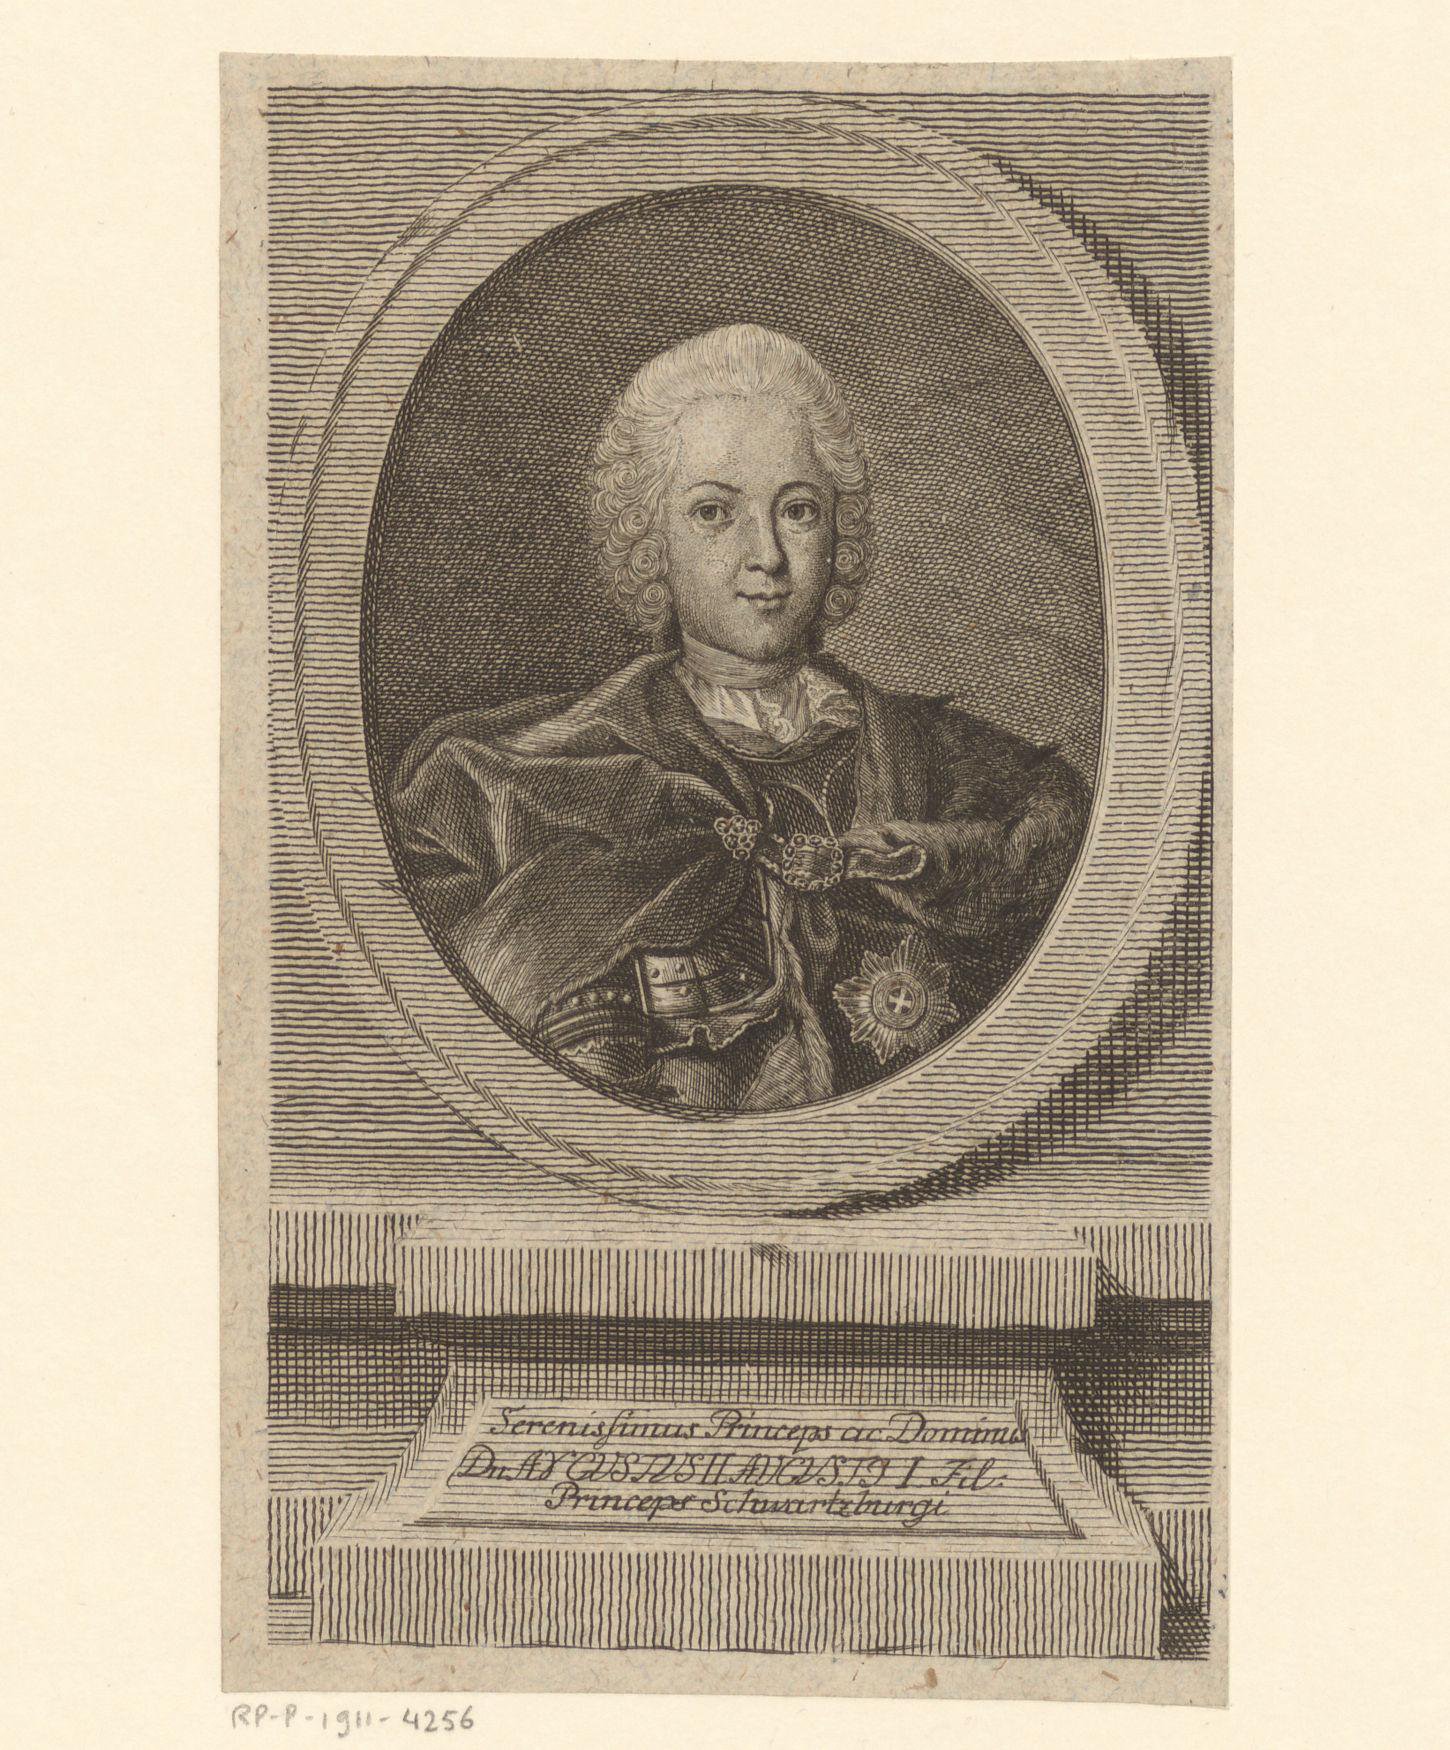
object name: print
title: Portret van August II von Schwarzburg-Sondershausen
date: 1750-1800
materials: paper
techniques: engraving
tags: armour, historical persons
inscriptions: collector's mark: Lugt 2228